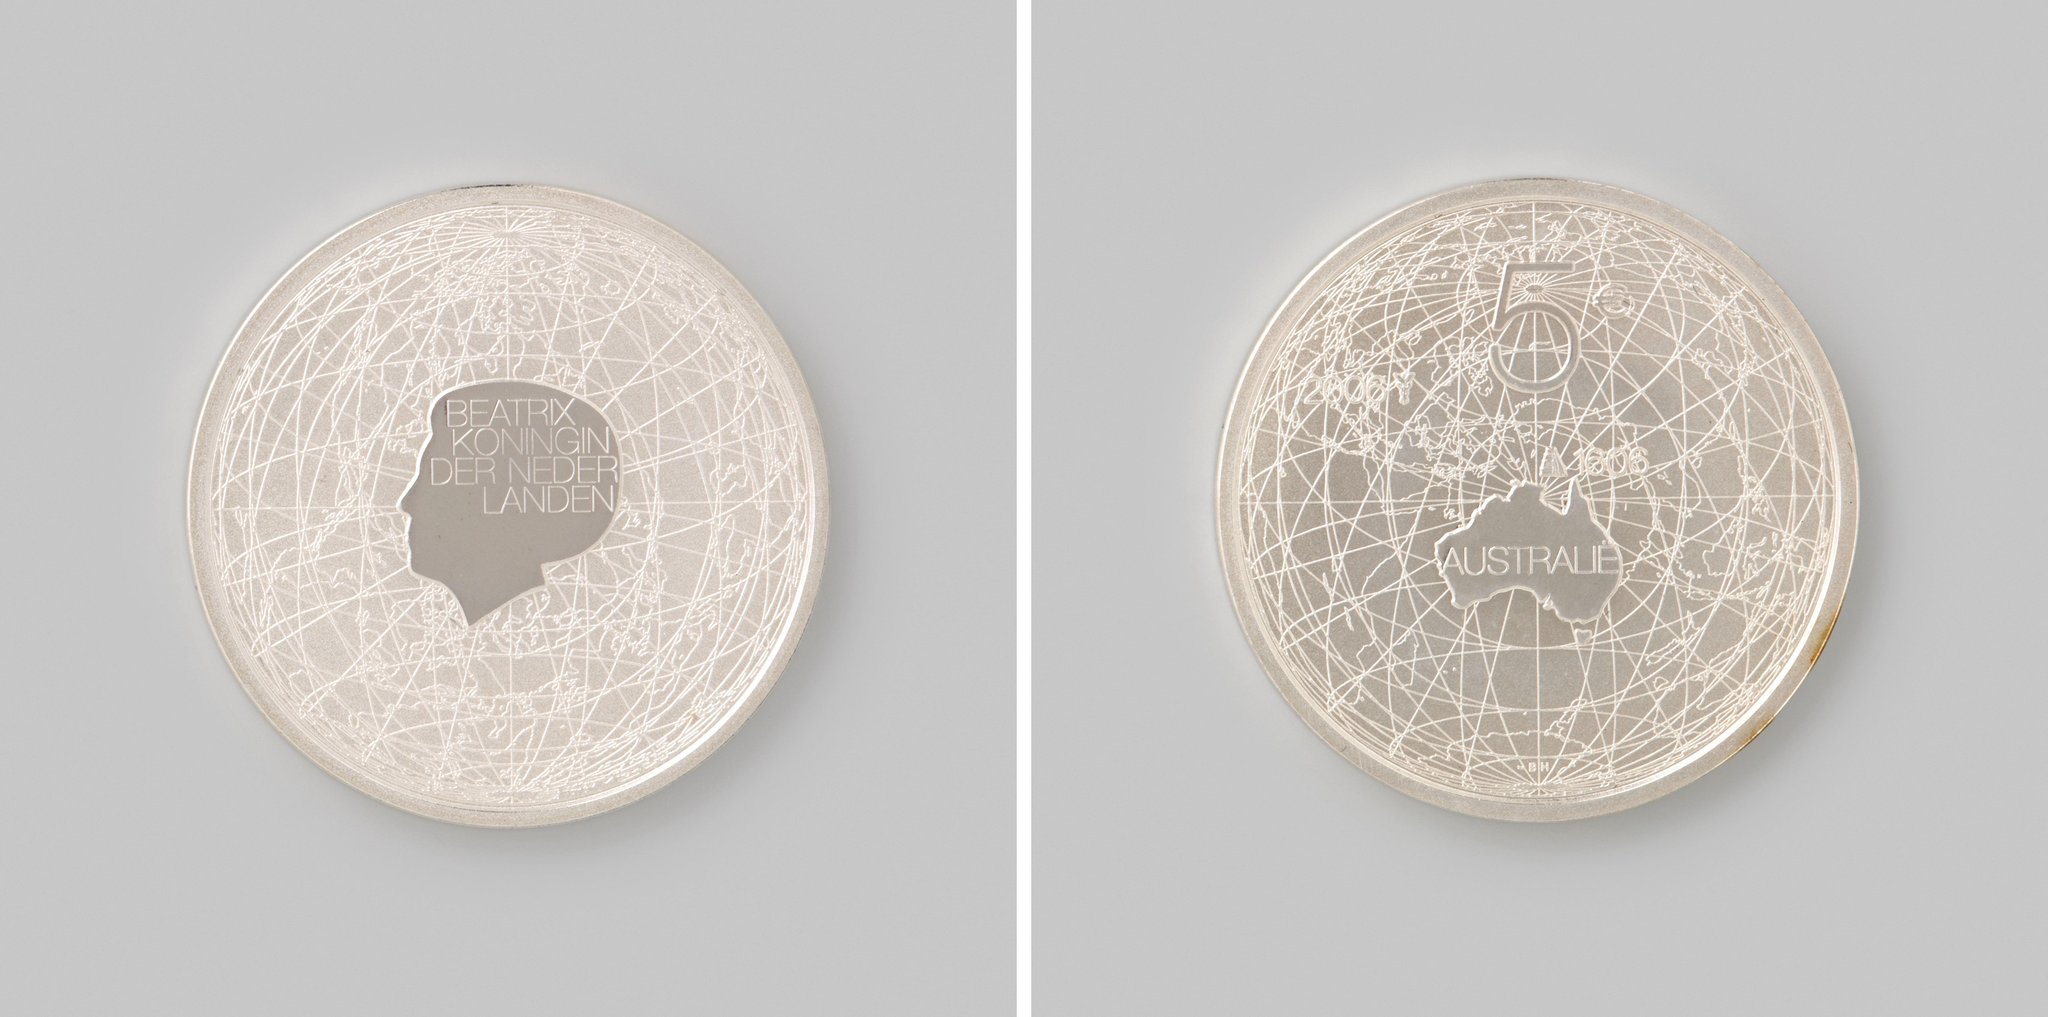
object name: coin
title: Eerste slag : Het Australië Vijfje 2006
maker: irma boom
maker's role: grafisch ontwerper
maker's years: 1960-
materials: silver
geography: netherlands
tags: beatrix (koningin der nederlanden), netherlands, australia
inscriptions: inscription: ‘BEATRIX KONINGIN DER NEDERLANDEN’, edge inscription: ‘GOD ZIJ MET ONS’, inscription: ‘AUSTRALIË 1606-2006 5 €’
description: Zilveren munt van vijf Euro. Voorzijde: vlak silhouet van koningin Beatrix naar links gewend, waarin opschrift, geplaatst op een lijnenspel van zes globes en routelijnen van de VOC. Keerzijde: vlak gestileerd Australië met opschrift geplaatst op idem lijnenspel, met opschrift en nominale waarde. Het Nederlandse muntmeesterteken (koerszettende zeilen) staat afgebeeld op de plek waar ‘t Duyfken aan land is gegaan. Randschrift. Munt gevat in perspex. Bijbehorend houten doosje met inleg.